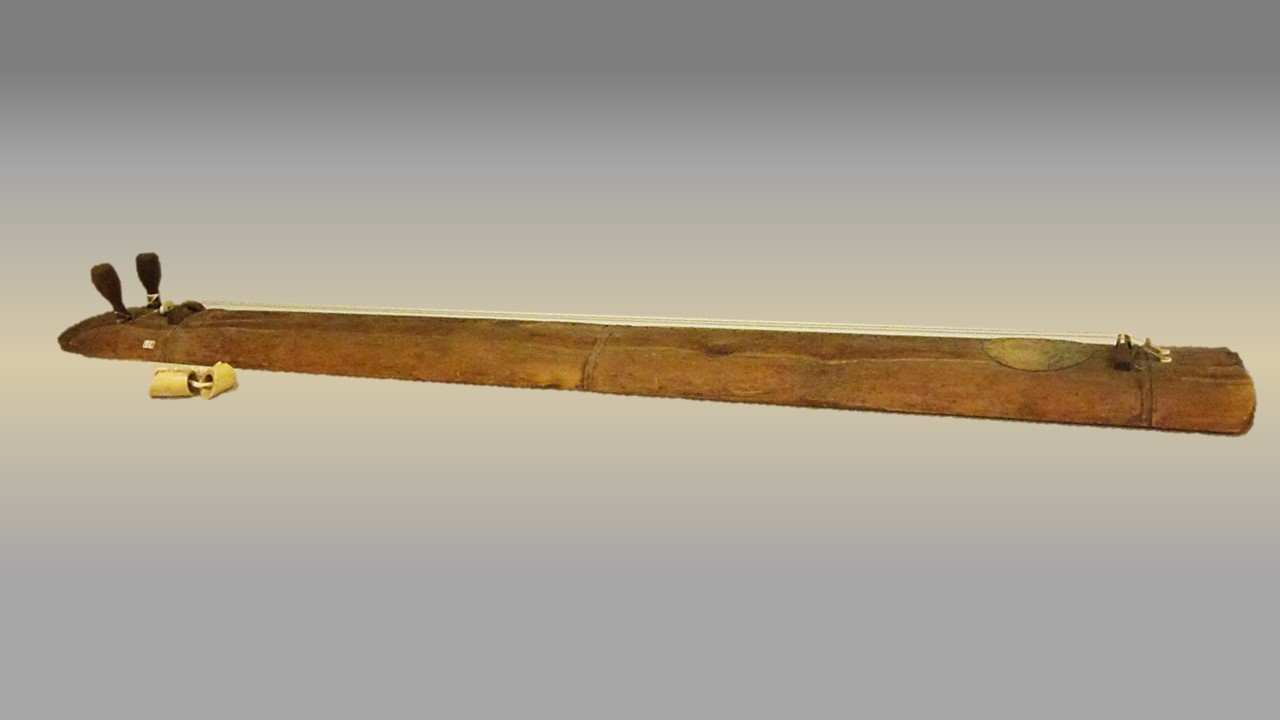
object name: nigenkin 二弦 琴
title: Nigenkin ( 二弦 琴 )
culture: japanese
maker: asano tōshichi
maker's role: maker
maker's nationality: japanese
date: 1801-1900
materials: bamboo, wood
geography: japan